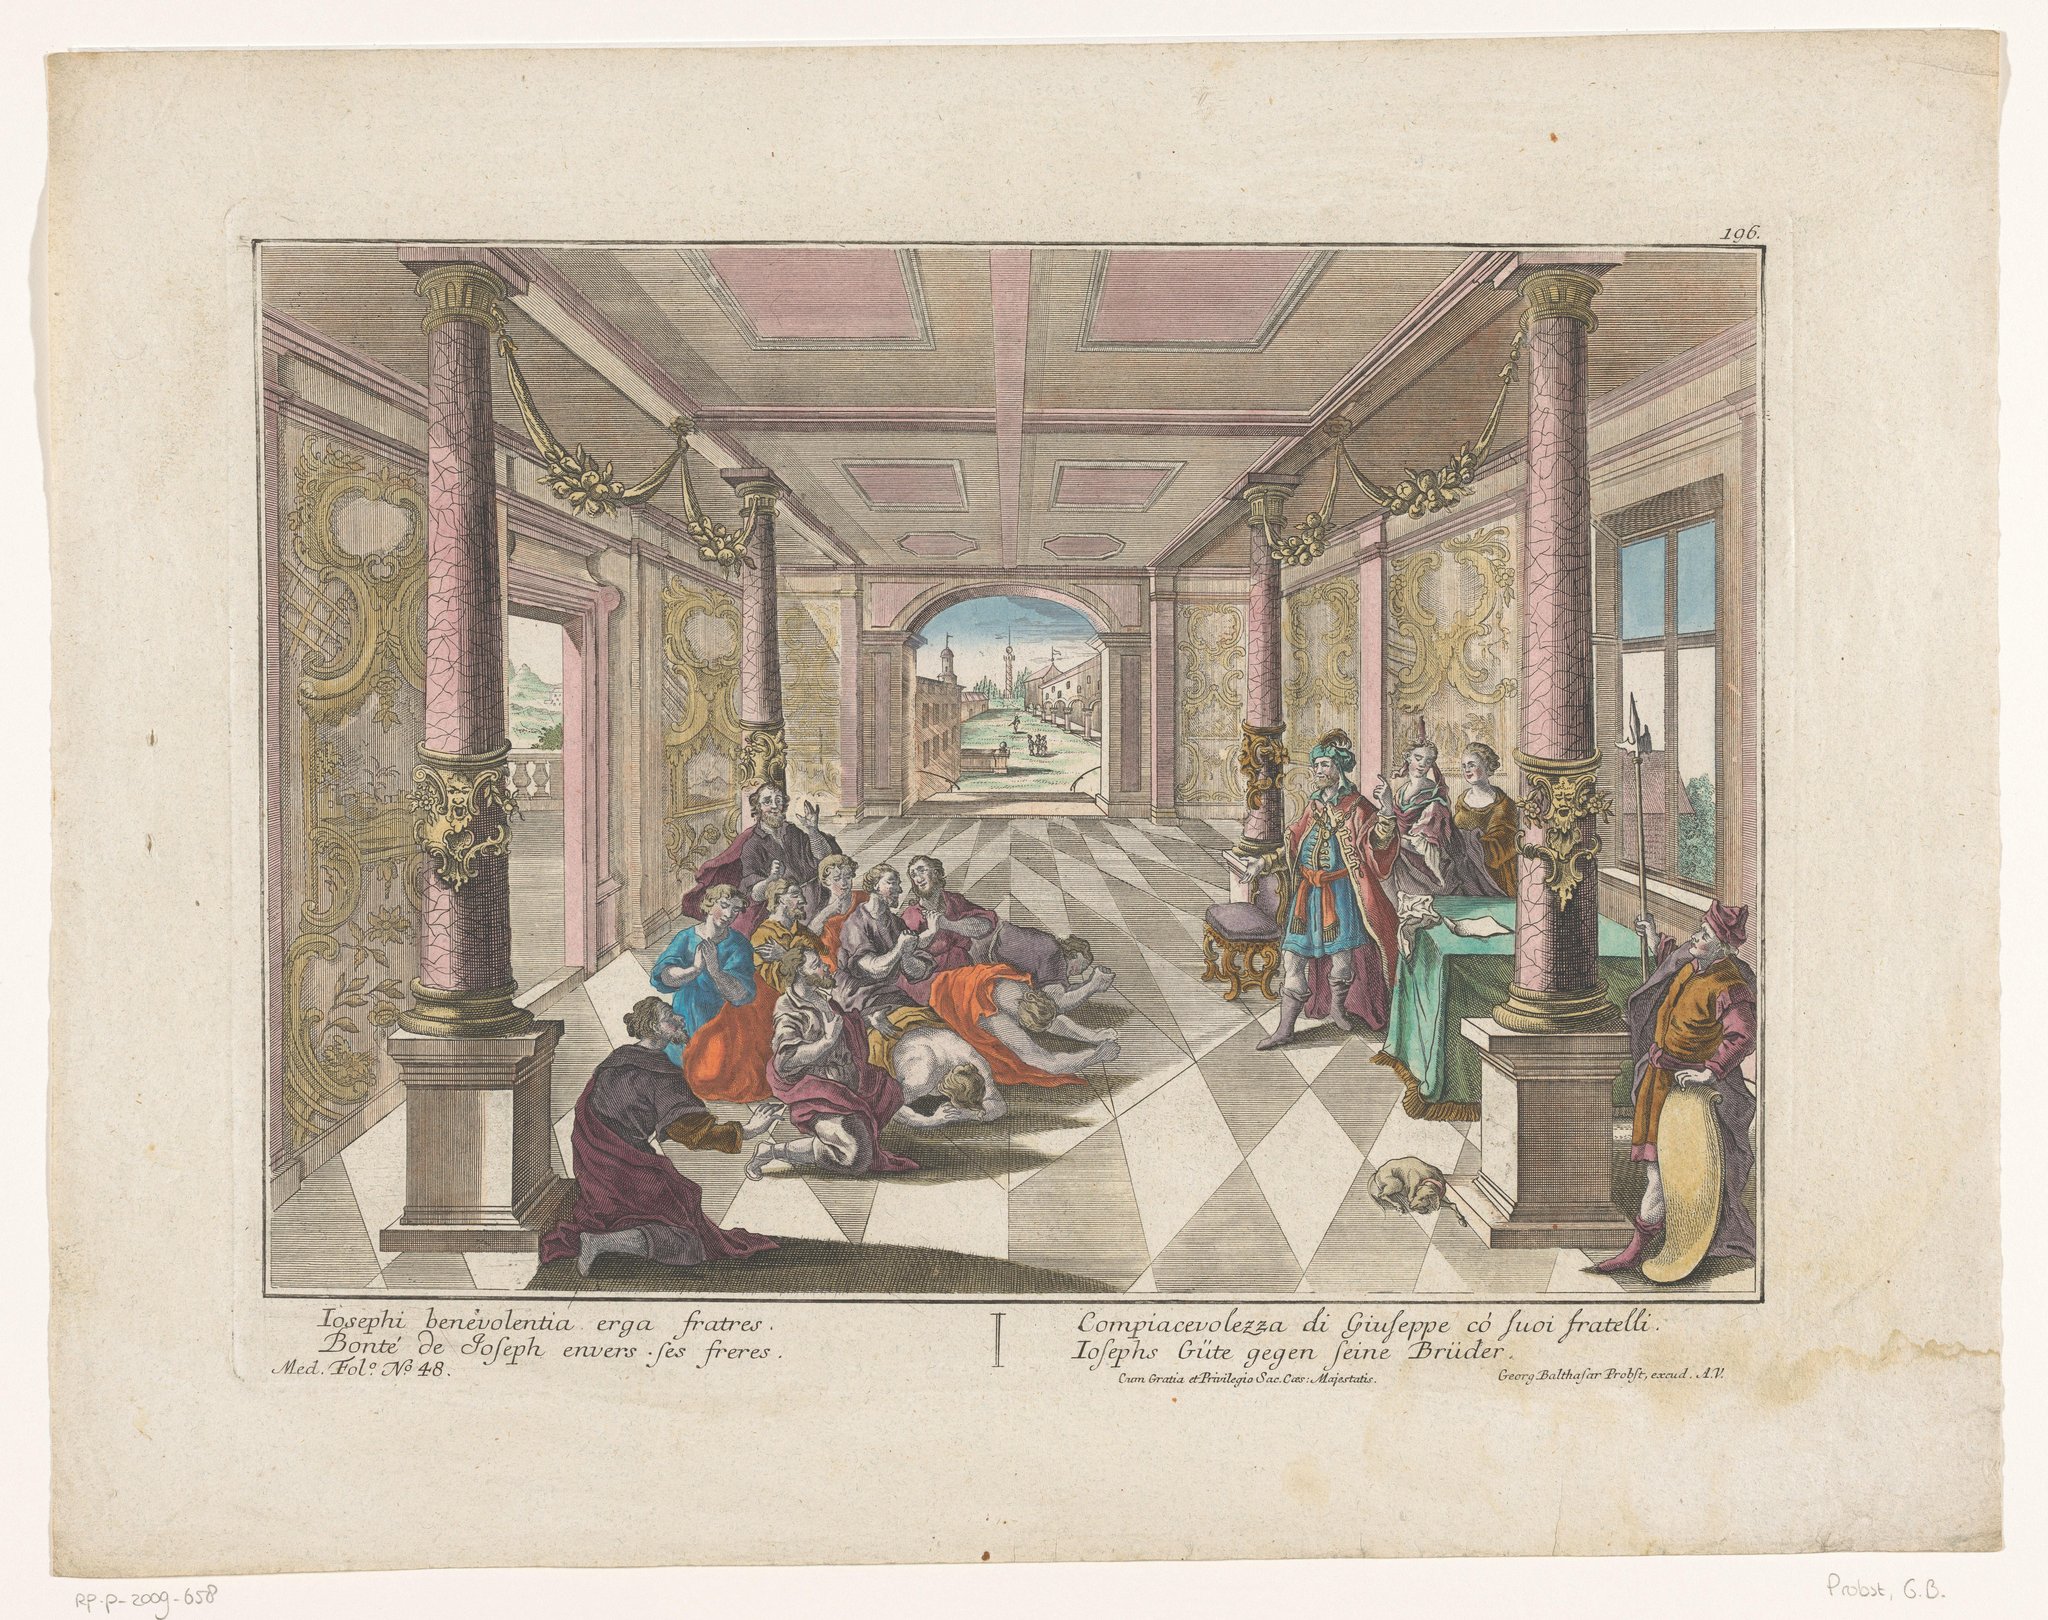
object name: print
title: Iosephs Güte gegen seine Brüder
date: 1742-1801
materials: paper, watercolor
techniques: brush, etching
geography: germany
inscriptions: collector's mark: Lugt 2228, watermark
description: In een paleiszaal staat Jozef rechts in fraaie kleding naast een tafel met een glad en een verfommeld blad papier erop.. Links knielen 11 eenvoudig geklede mannen. Onder de afbeelding de titel in vier talen.